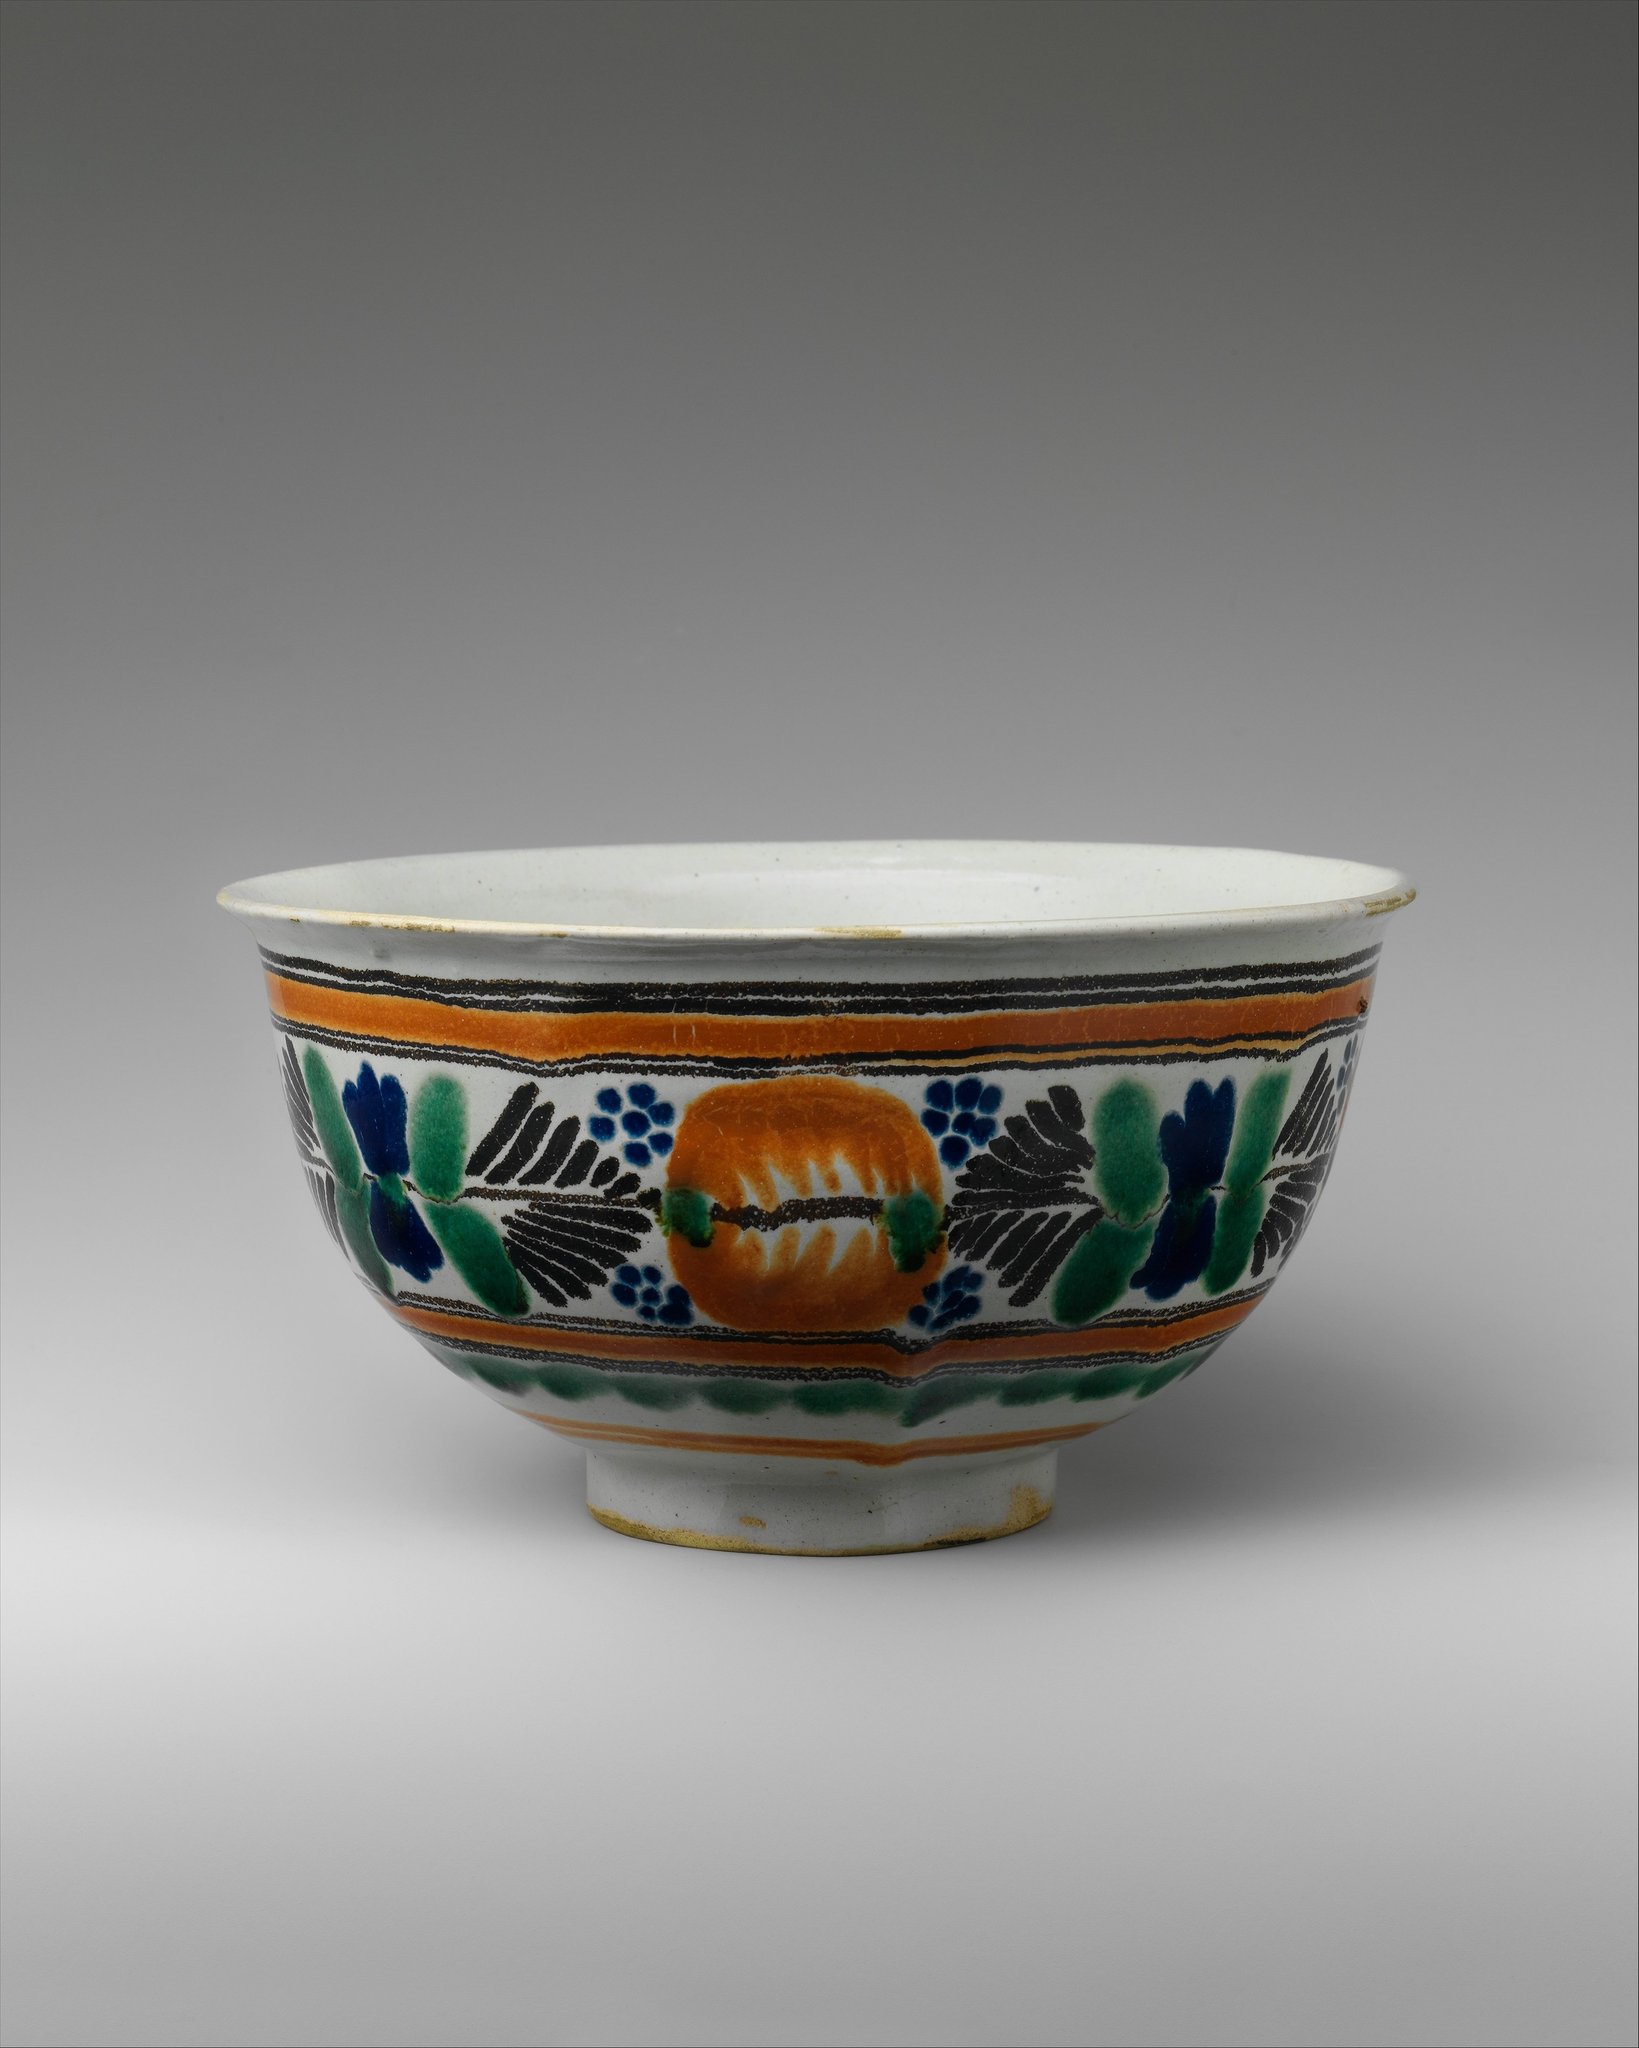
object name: bowl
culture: mexican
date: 1875-1900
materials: earthenware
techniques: glazing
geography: mexico